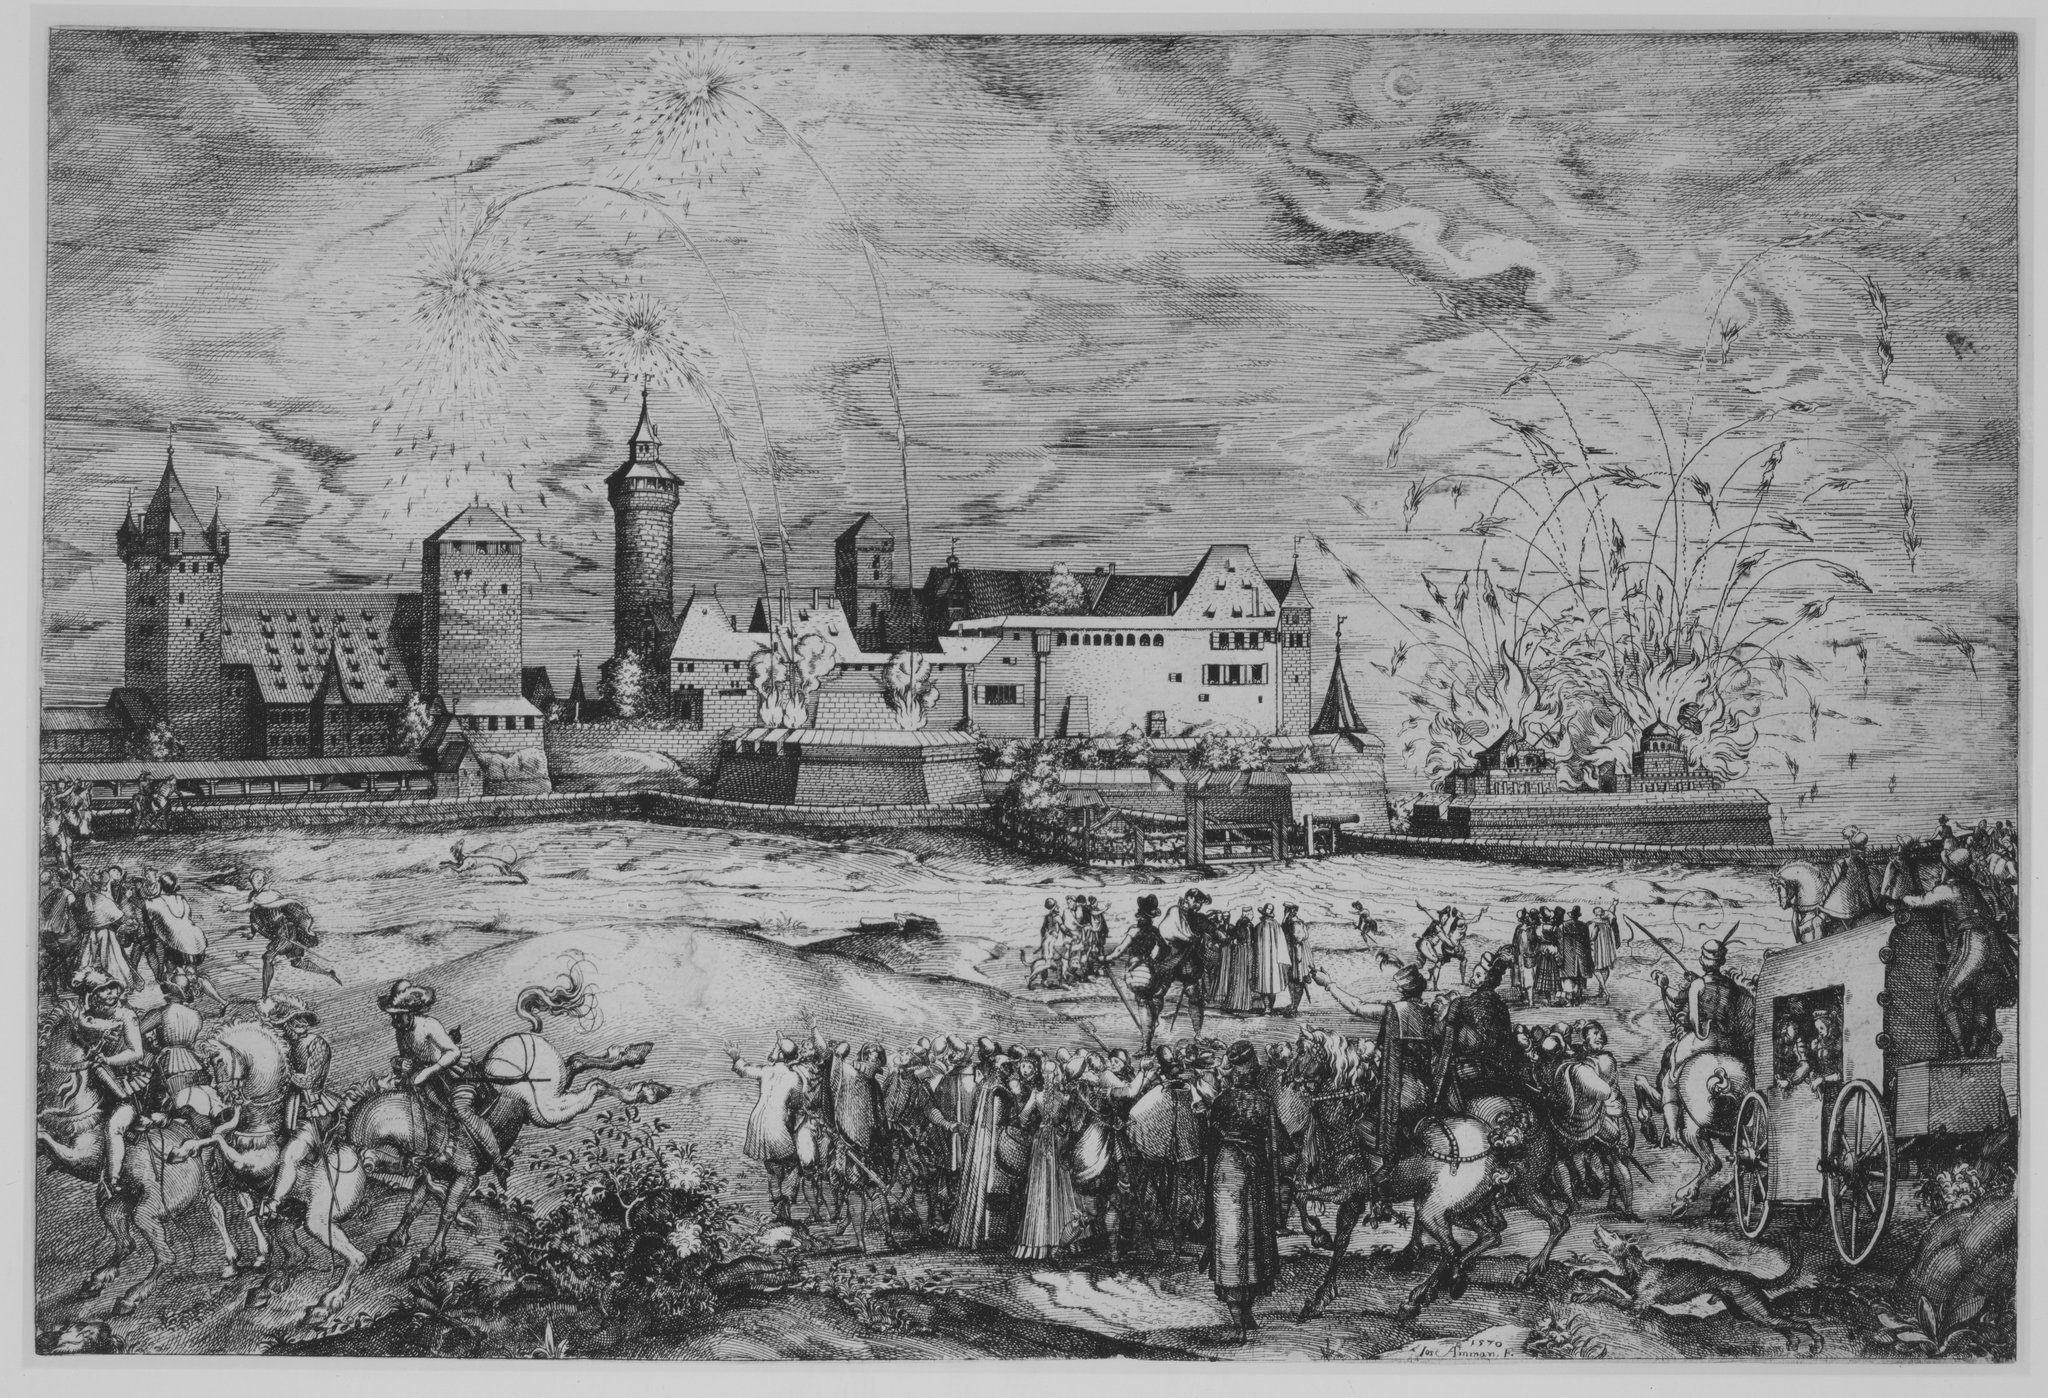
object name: print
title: Entry of Maximilian II into Nuremberg, June 7, 1570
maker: jost amman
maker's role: artist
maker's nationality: swiss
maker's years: 1539-1591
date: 1570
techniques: engraving, etching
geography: germany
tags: buildings,men,horses,crowd,carriages